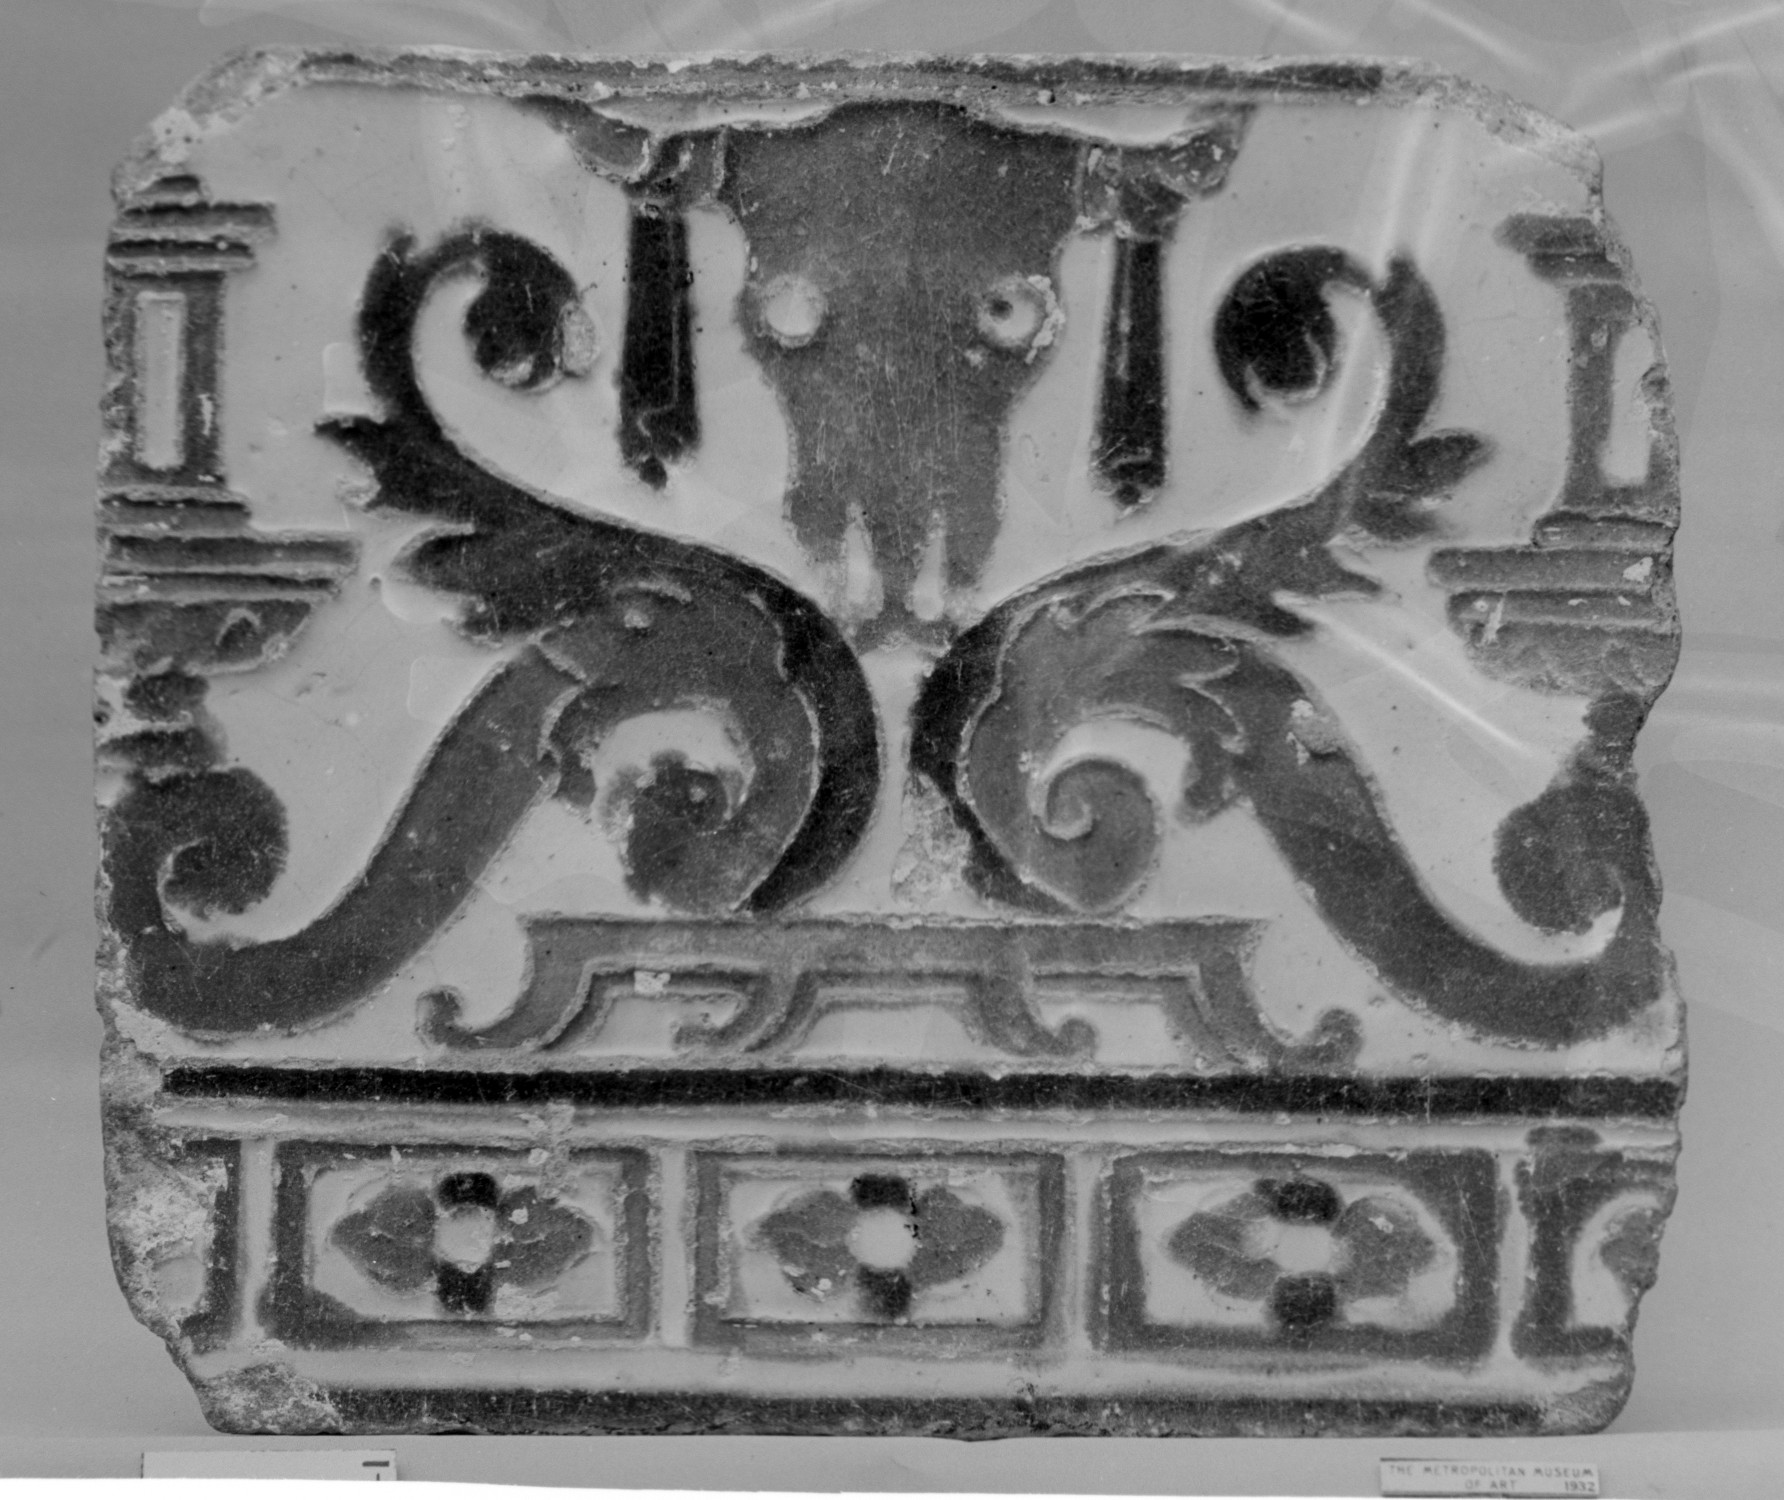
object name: tile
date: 1567-1600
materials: earthenware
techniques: glazing